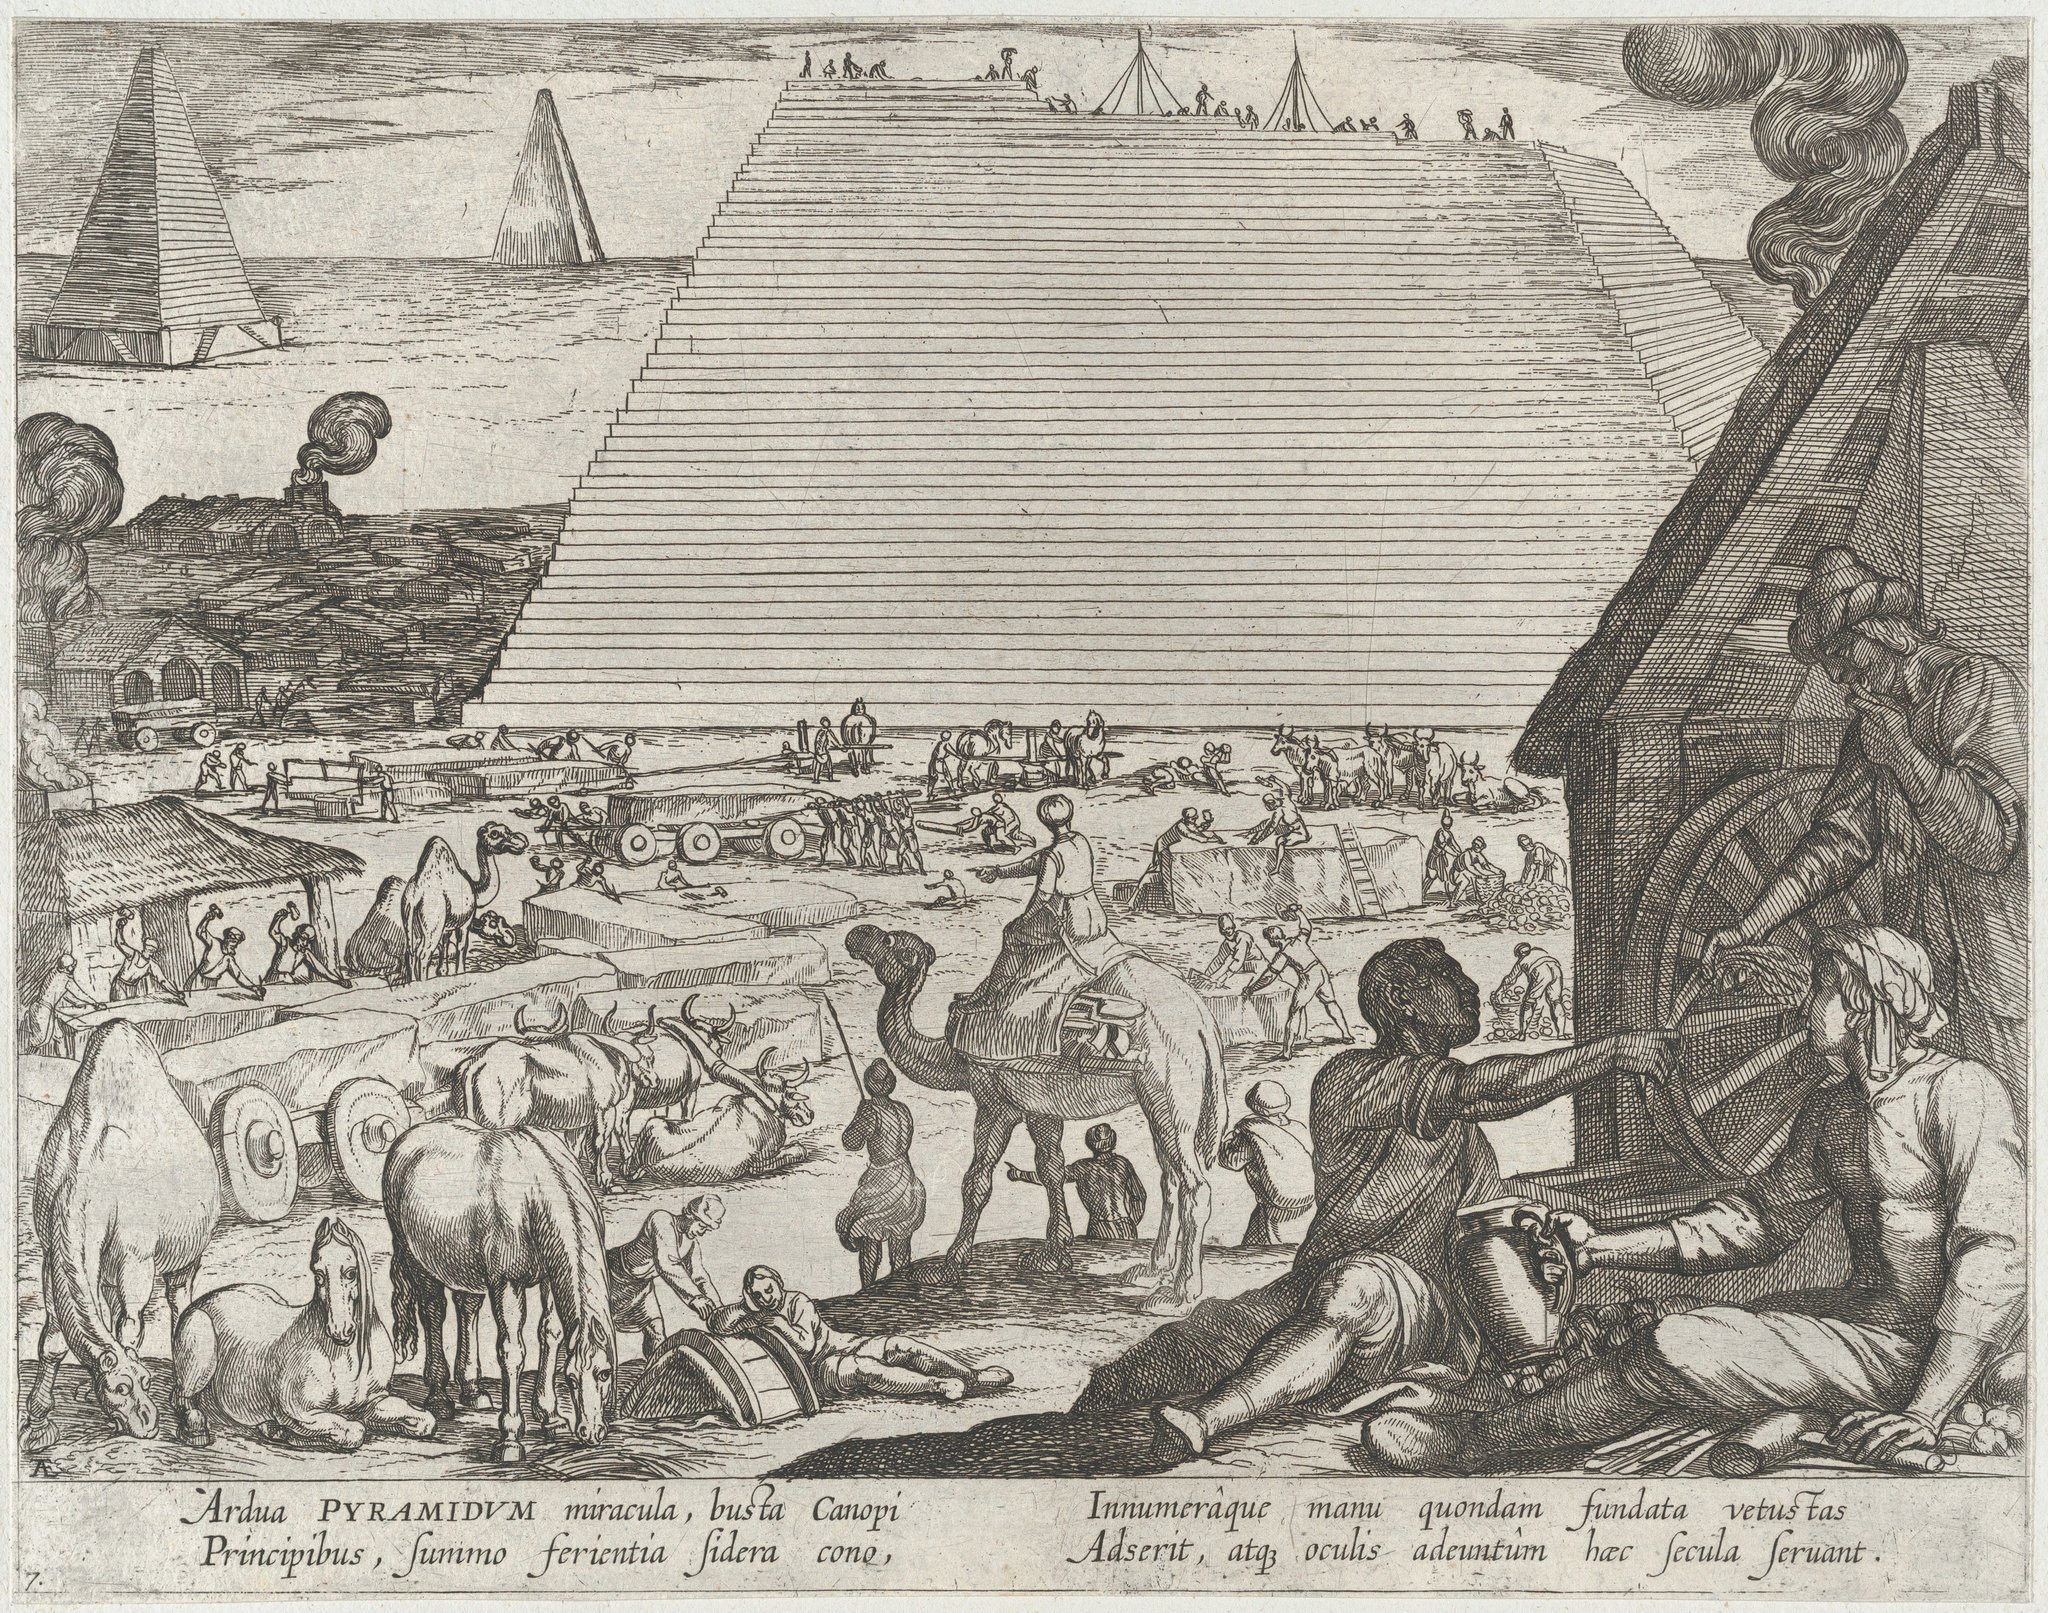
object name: print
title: The Pyramids in Egypt, plate 7 from "The Seven Wonders of The World"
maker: antonio tempesta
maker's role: artist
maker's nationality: italian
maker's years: 1555-1630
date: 1608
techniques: etching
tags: pyramids,men,camels,horses